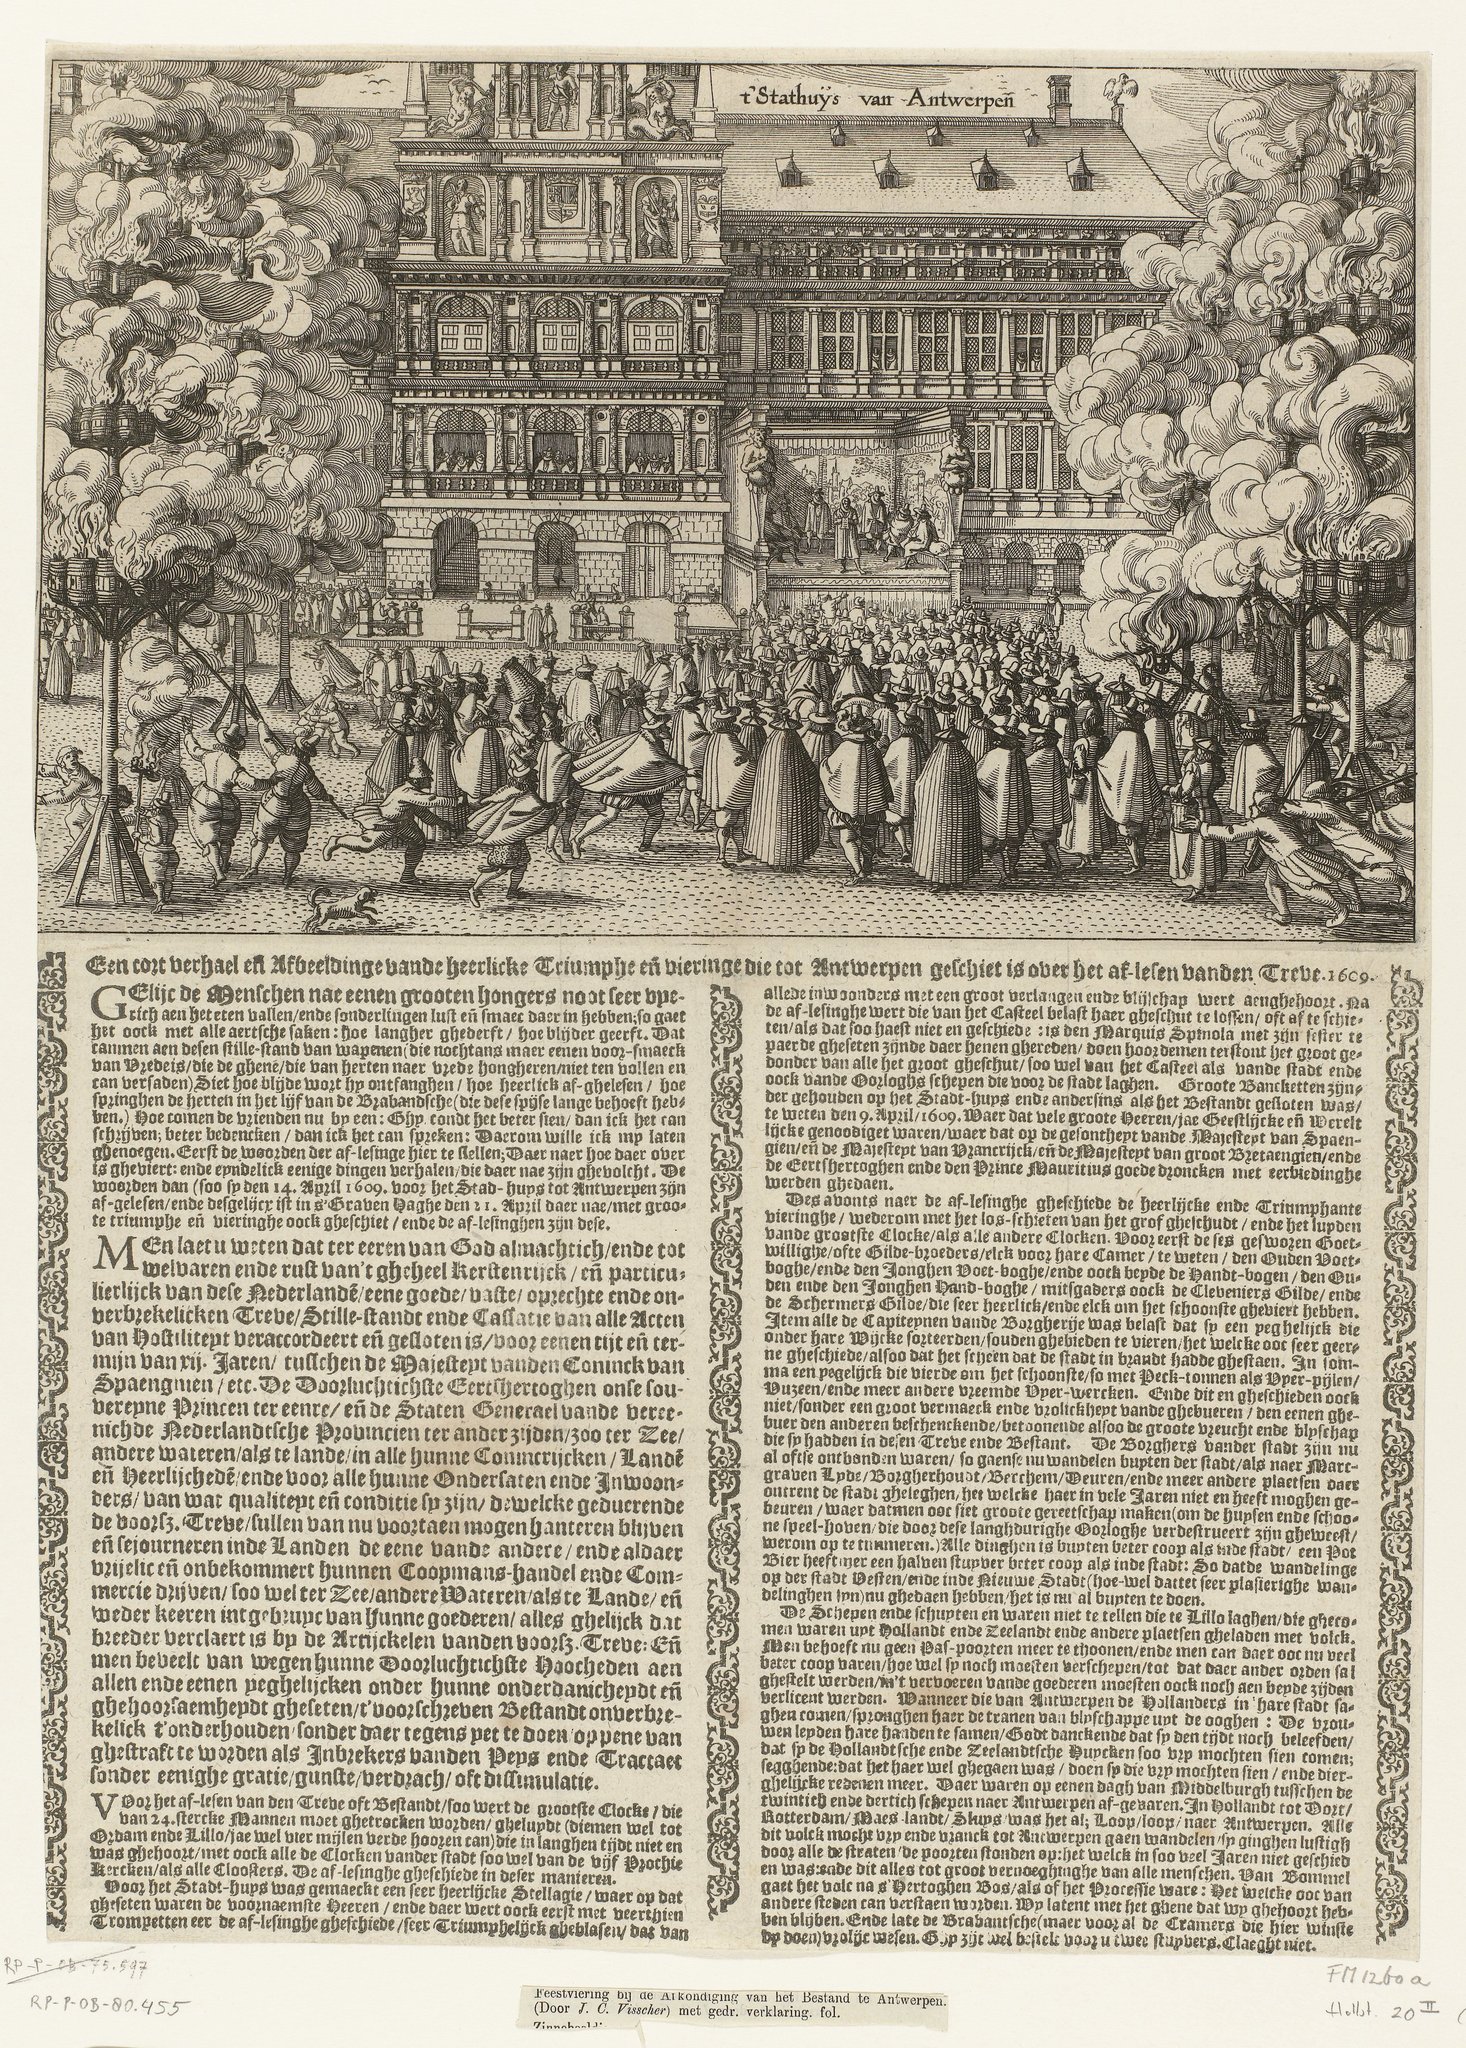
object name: print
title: Afkondiging van het bestand voor het stadhuis van Antwerpen, 1609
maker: claes jansz. visscher (ii)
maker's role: draughtsman, print maker, publisher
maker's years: 1586-1652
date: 1609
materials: paper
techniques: etching, letterpress printing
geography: amsterdam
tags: proclamation of peace, festivities on events of national importance (+ illumination, fire-works ~ festive activities)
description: De afkondiging van het bestand. De vrede gesloten op 9 april in Den Haag wordt bekend gemaakt en voorgelezen aan het publiek op de Grote Markt vanaf een podium opgesteld tegen de gevel van het stadhuis van Antwerpen, 14 april 1609. Links en rechts stellages met brandende pektonnen. Onder de voorstelling een gedrukte tekst in 2 kolommen met een beschrijving in het Nederlands.